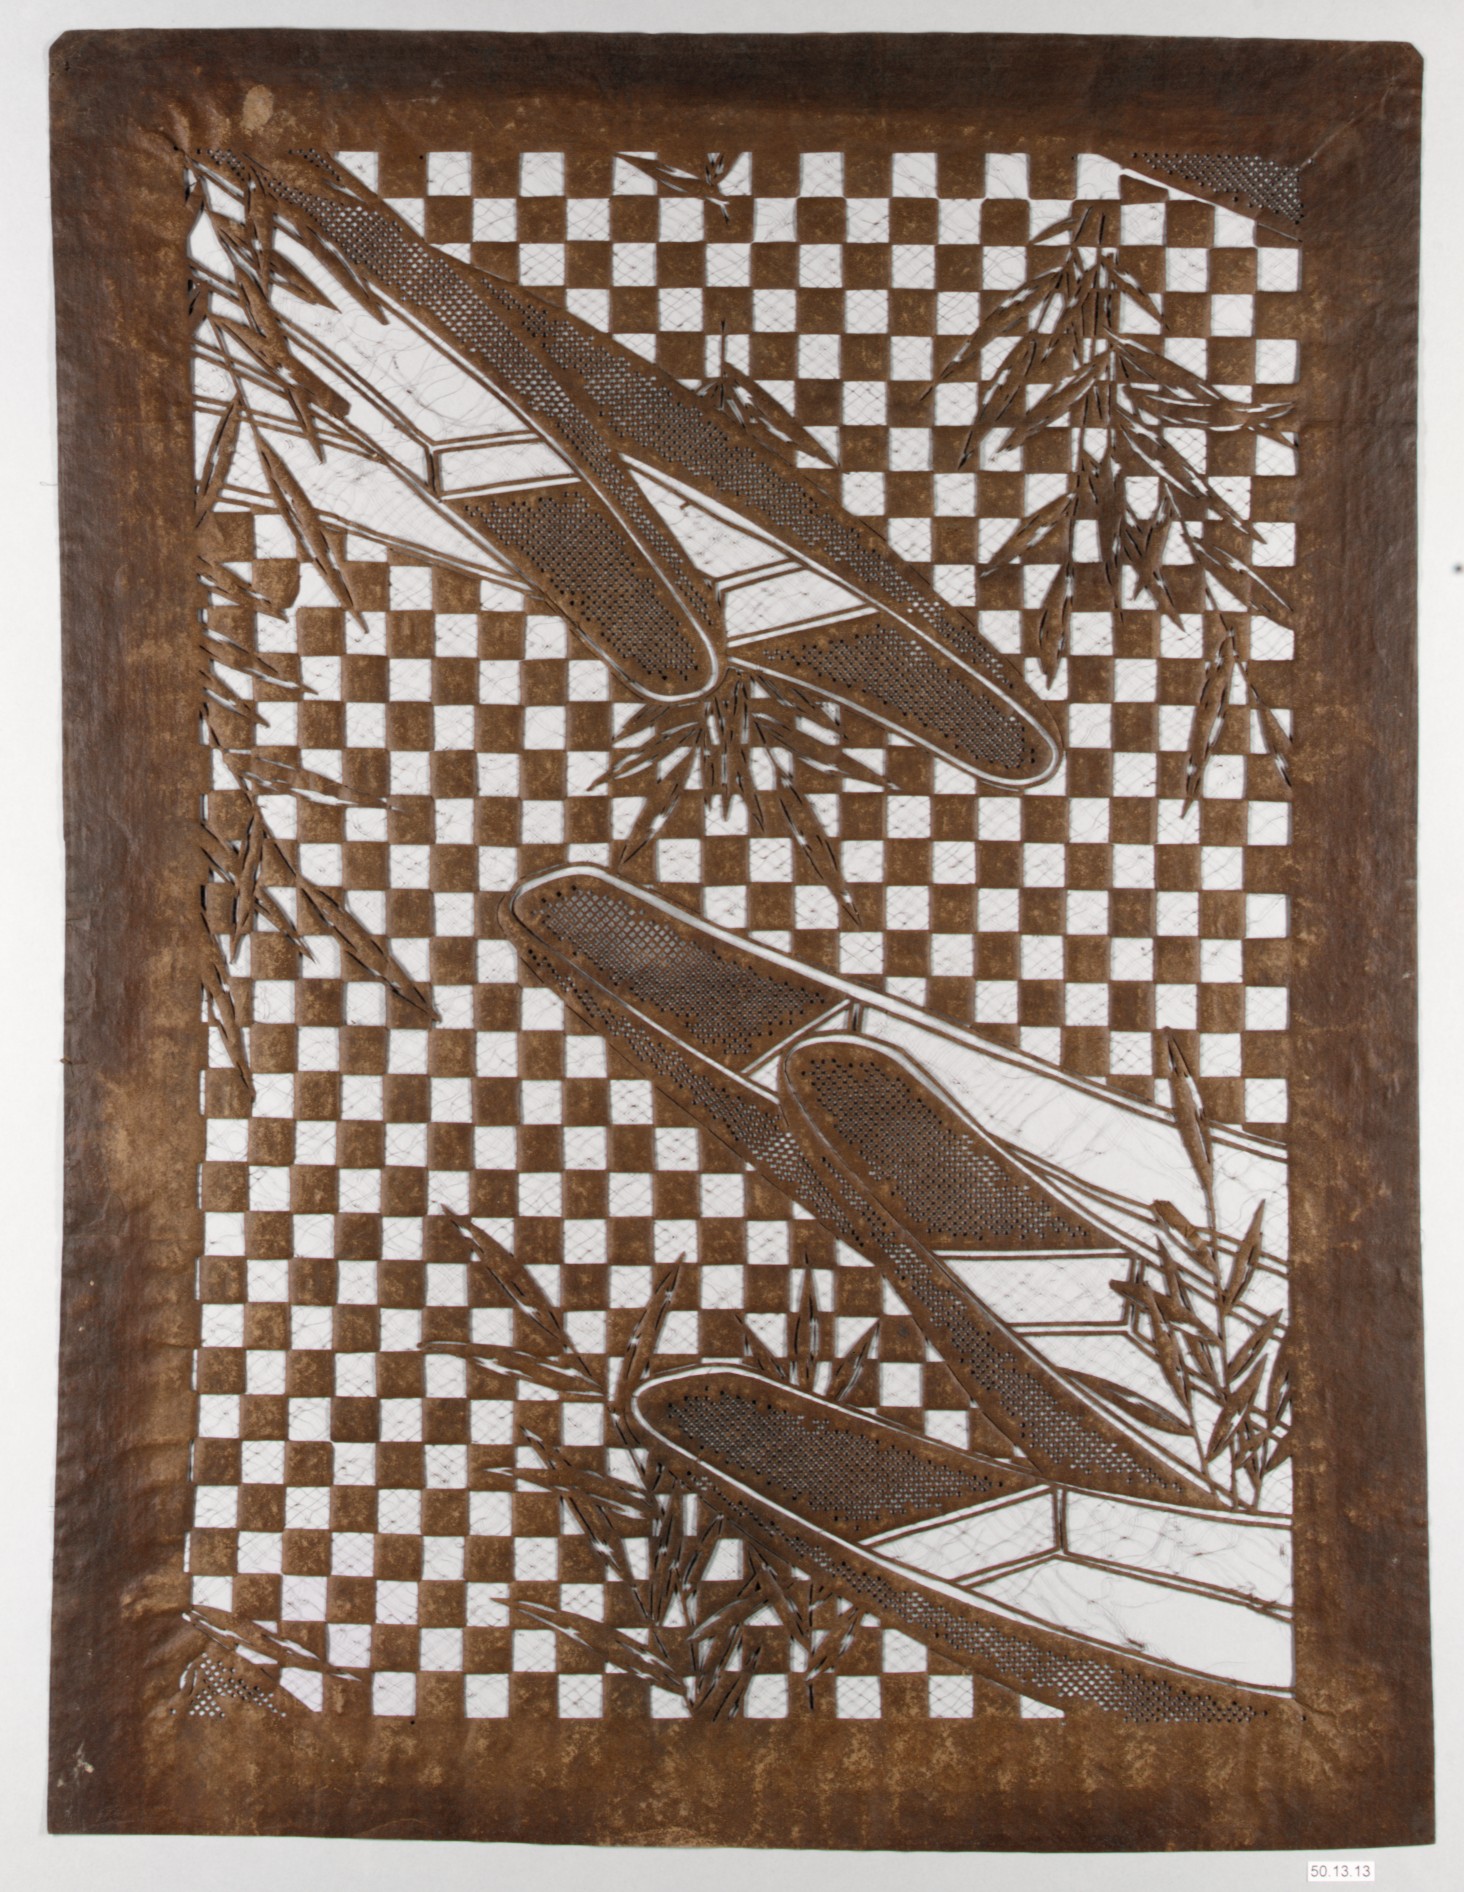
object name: stencil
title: Stencil with Pattern of Boats and Reeds on a Checked Background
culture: japanese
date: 1801-1900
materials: paper, silk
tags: boats